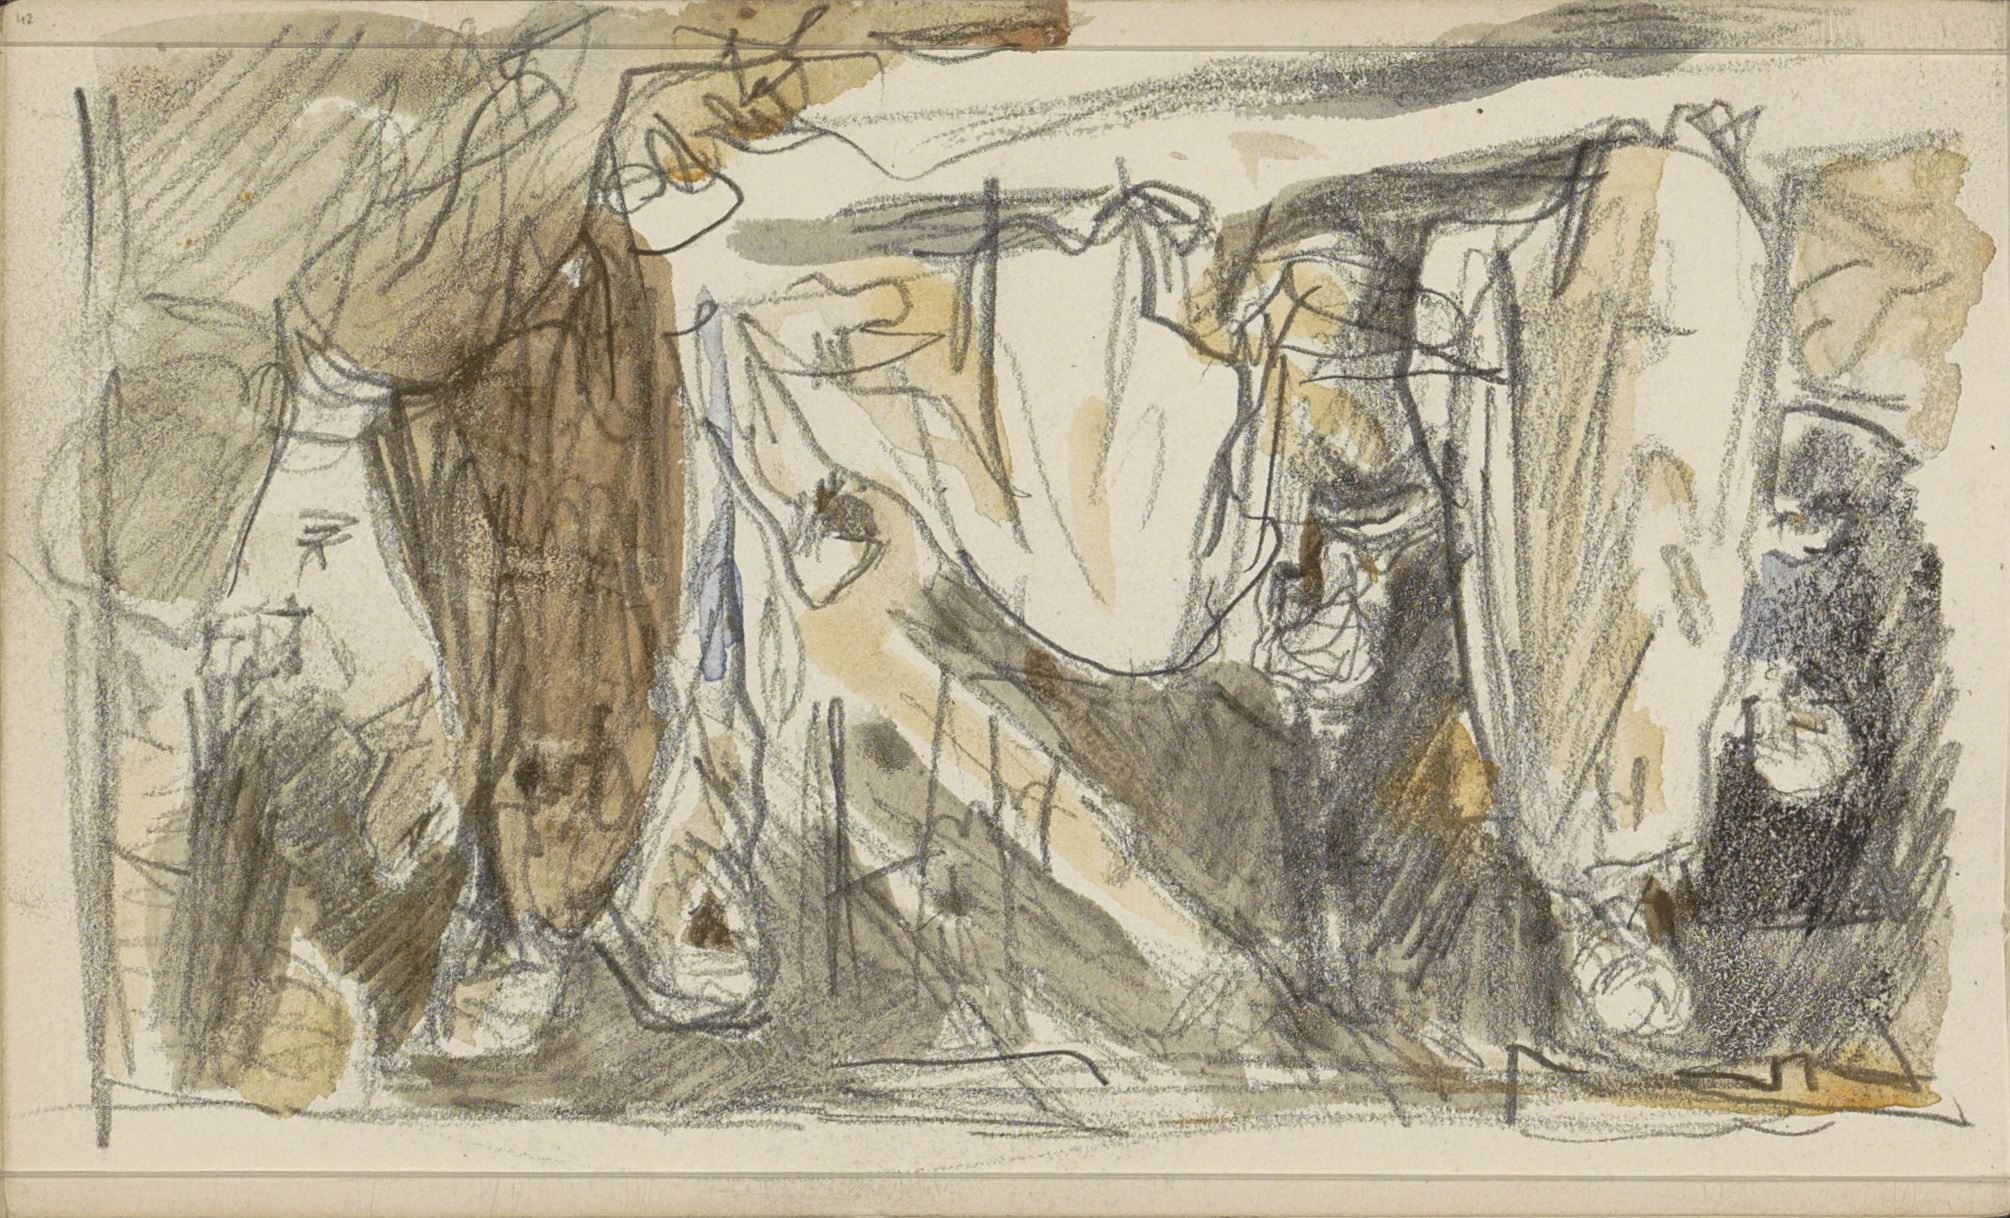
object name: sketchbook leaf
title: Straat met figuren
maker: marius bauer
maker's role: draughtsman, print maker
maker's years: 1867-1932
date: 1922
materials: chalk, paper, pencil, watercolor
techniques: brush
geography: biskra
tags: africans, street (+ city(-scape) with figures, staffage)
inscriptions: kleurnotitie, handgeschreven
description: Vermoedelijk een straat in Biskra. Pagina 42 uit een schetsboek met 31 bladen.